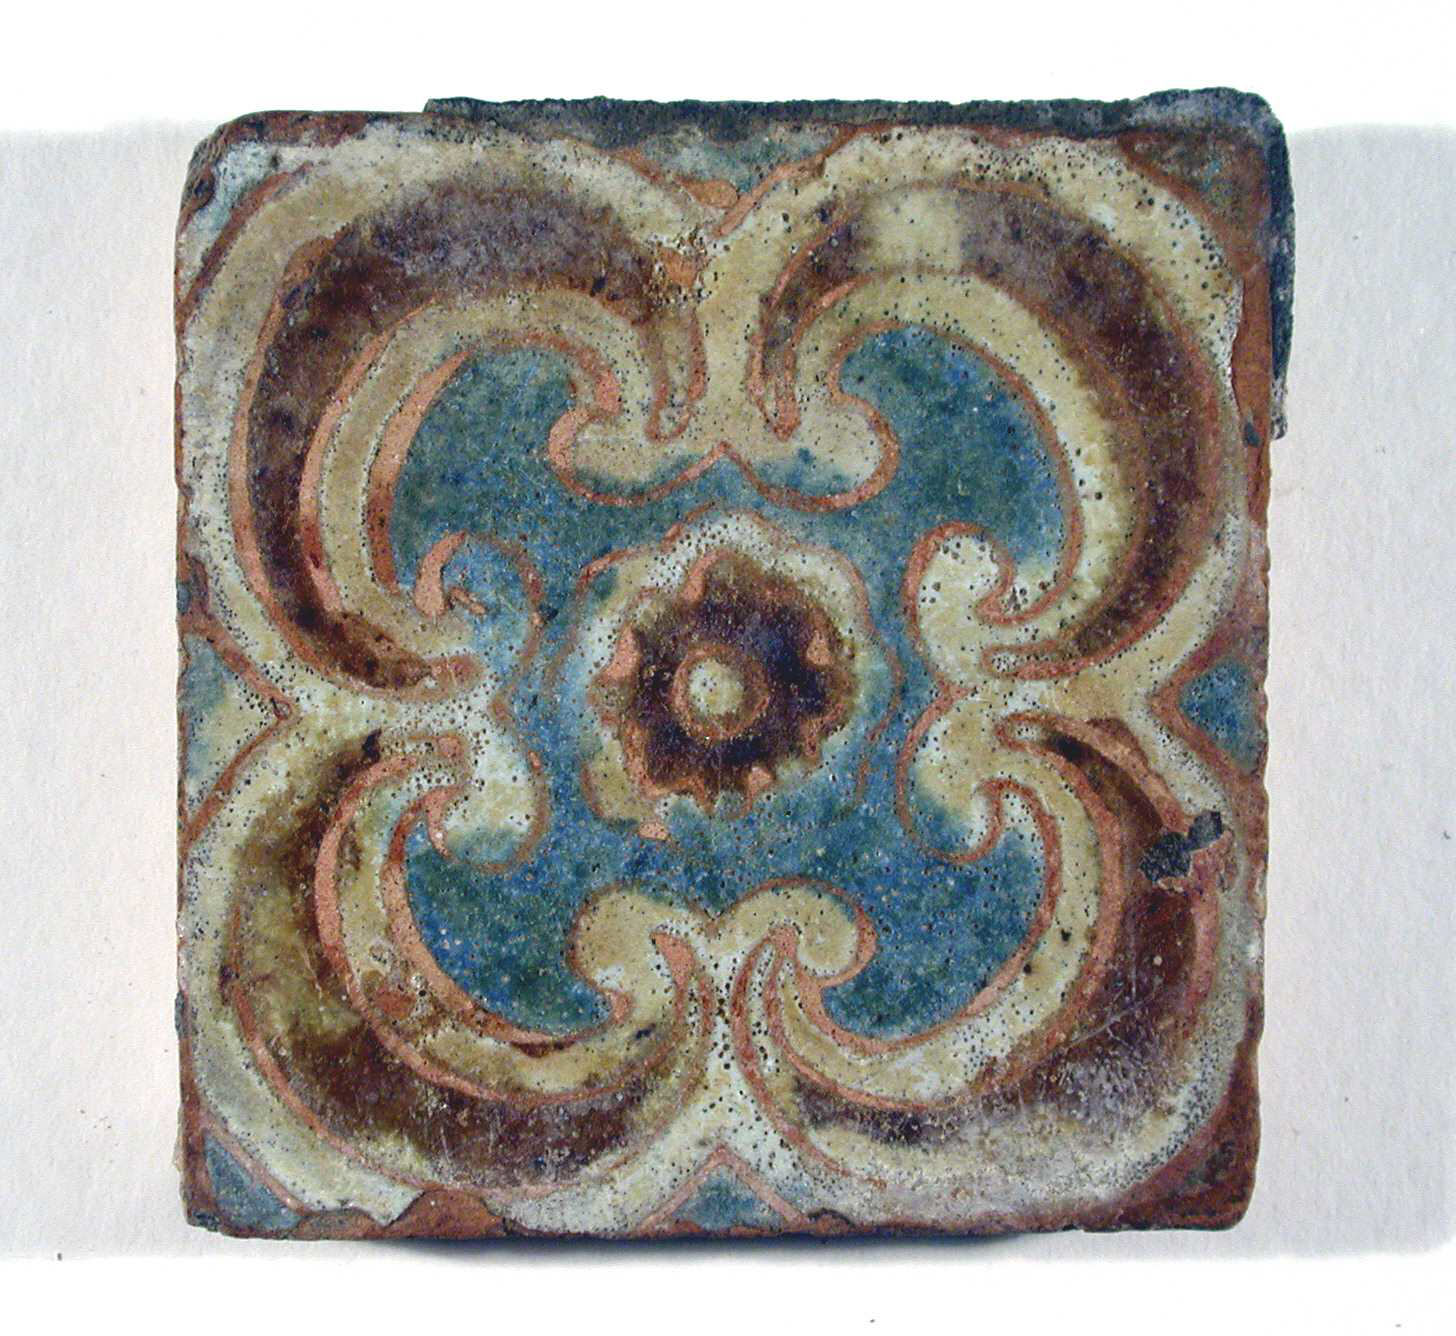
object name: pavement tile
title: Pavement tiles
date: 1501-1700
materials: earthenware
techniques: glazing